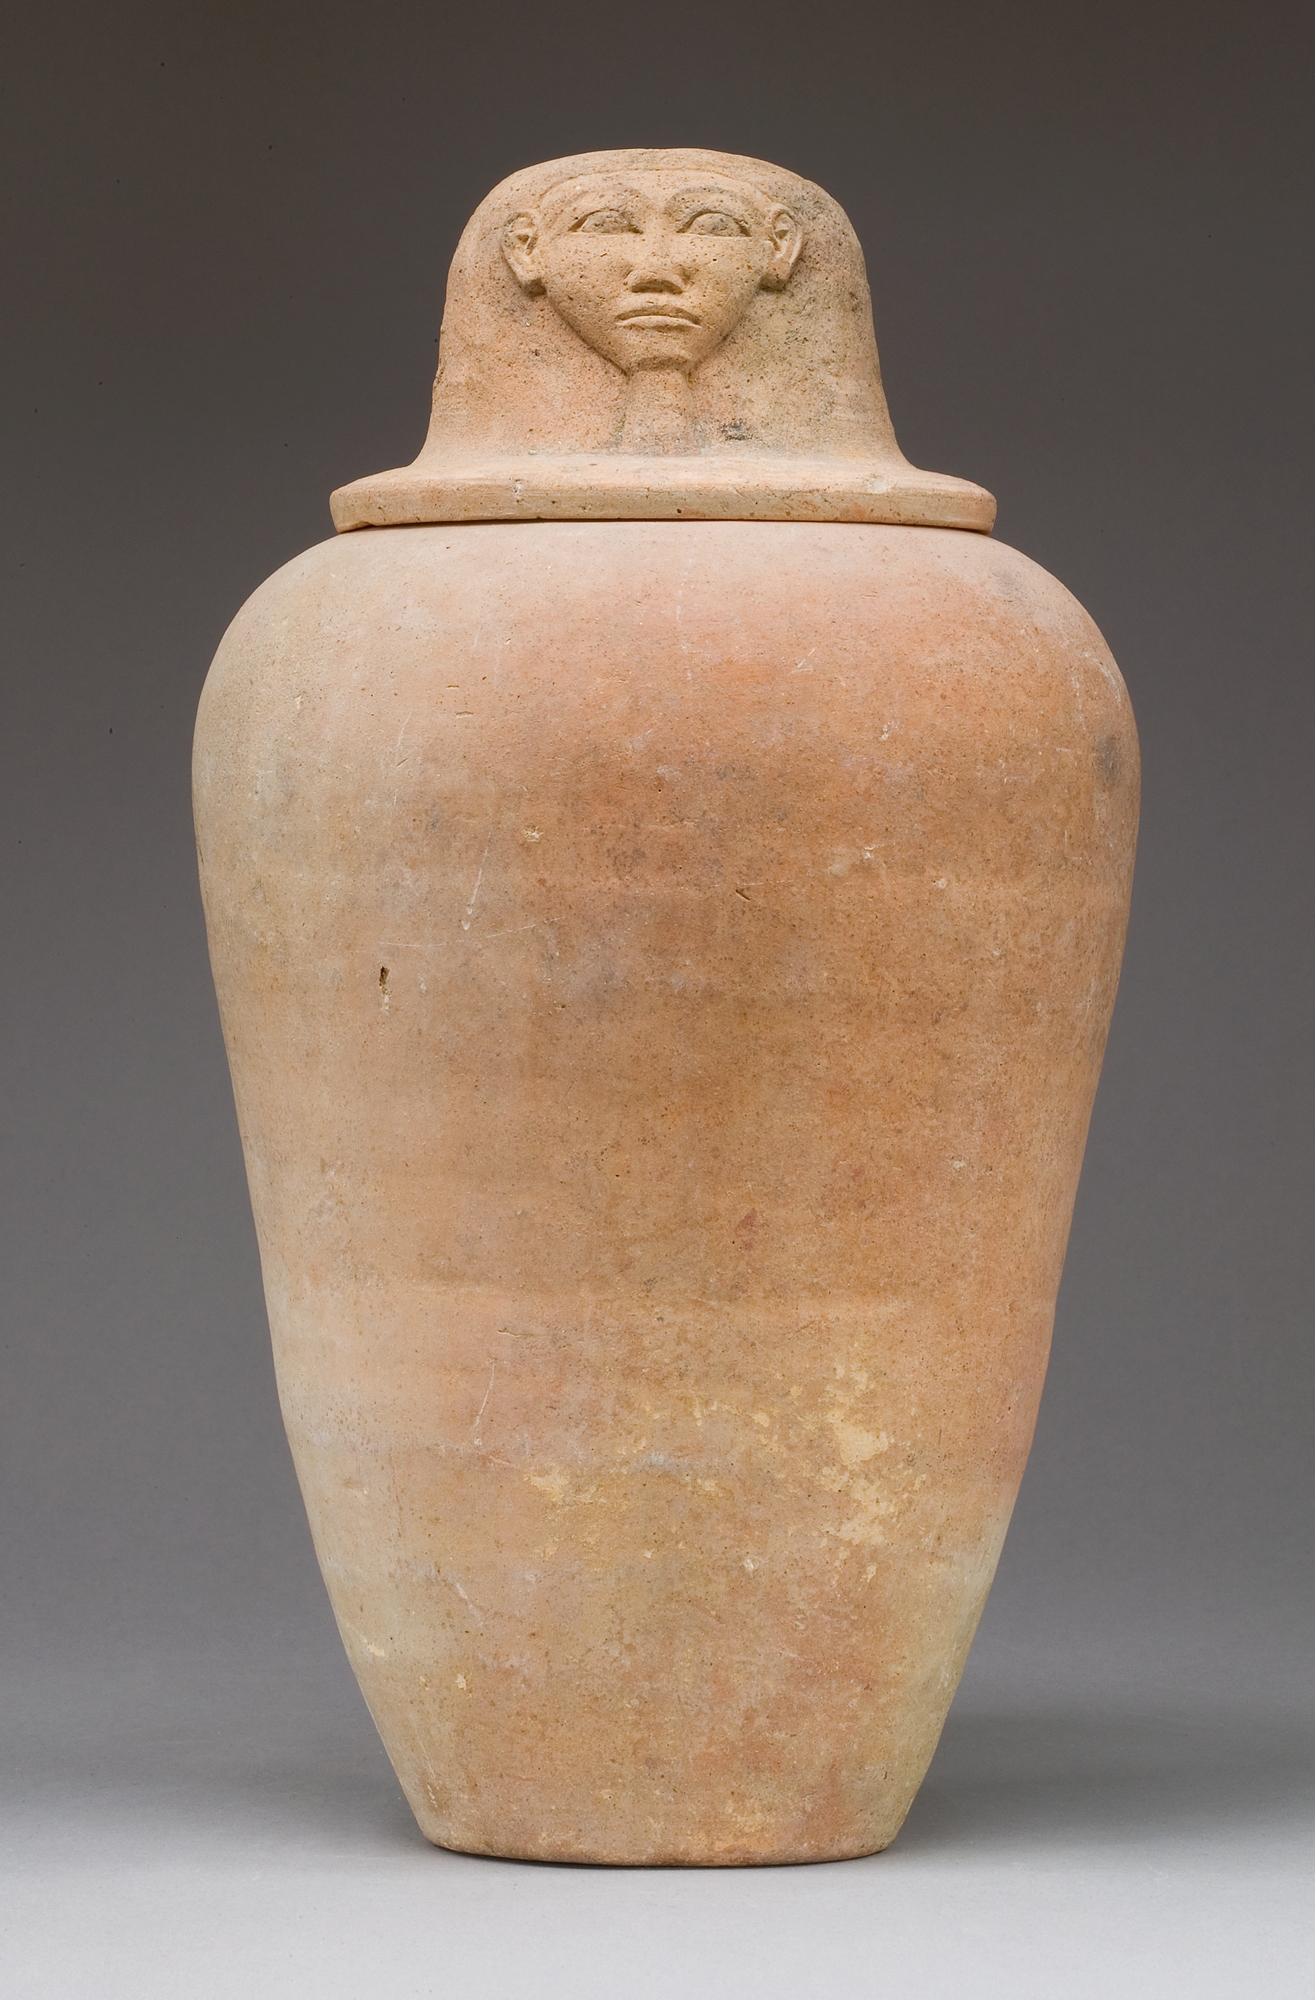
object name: canopic jar, human head, bearded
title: Canopic Jar with an Image Representing the Hieroglyph for Face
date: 1550-1450 BCE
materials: paint, pottery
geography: egypt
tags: hieroglyphs